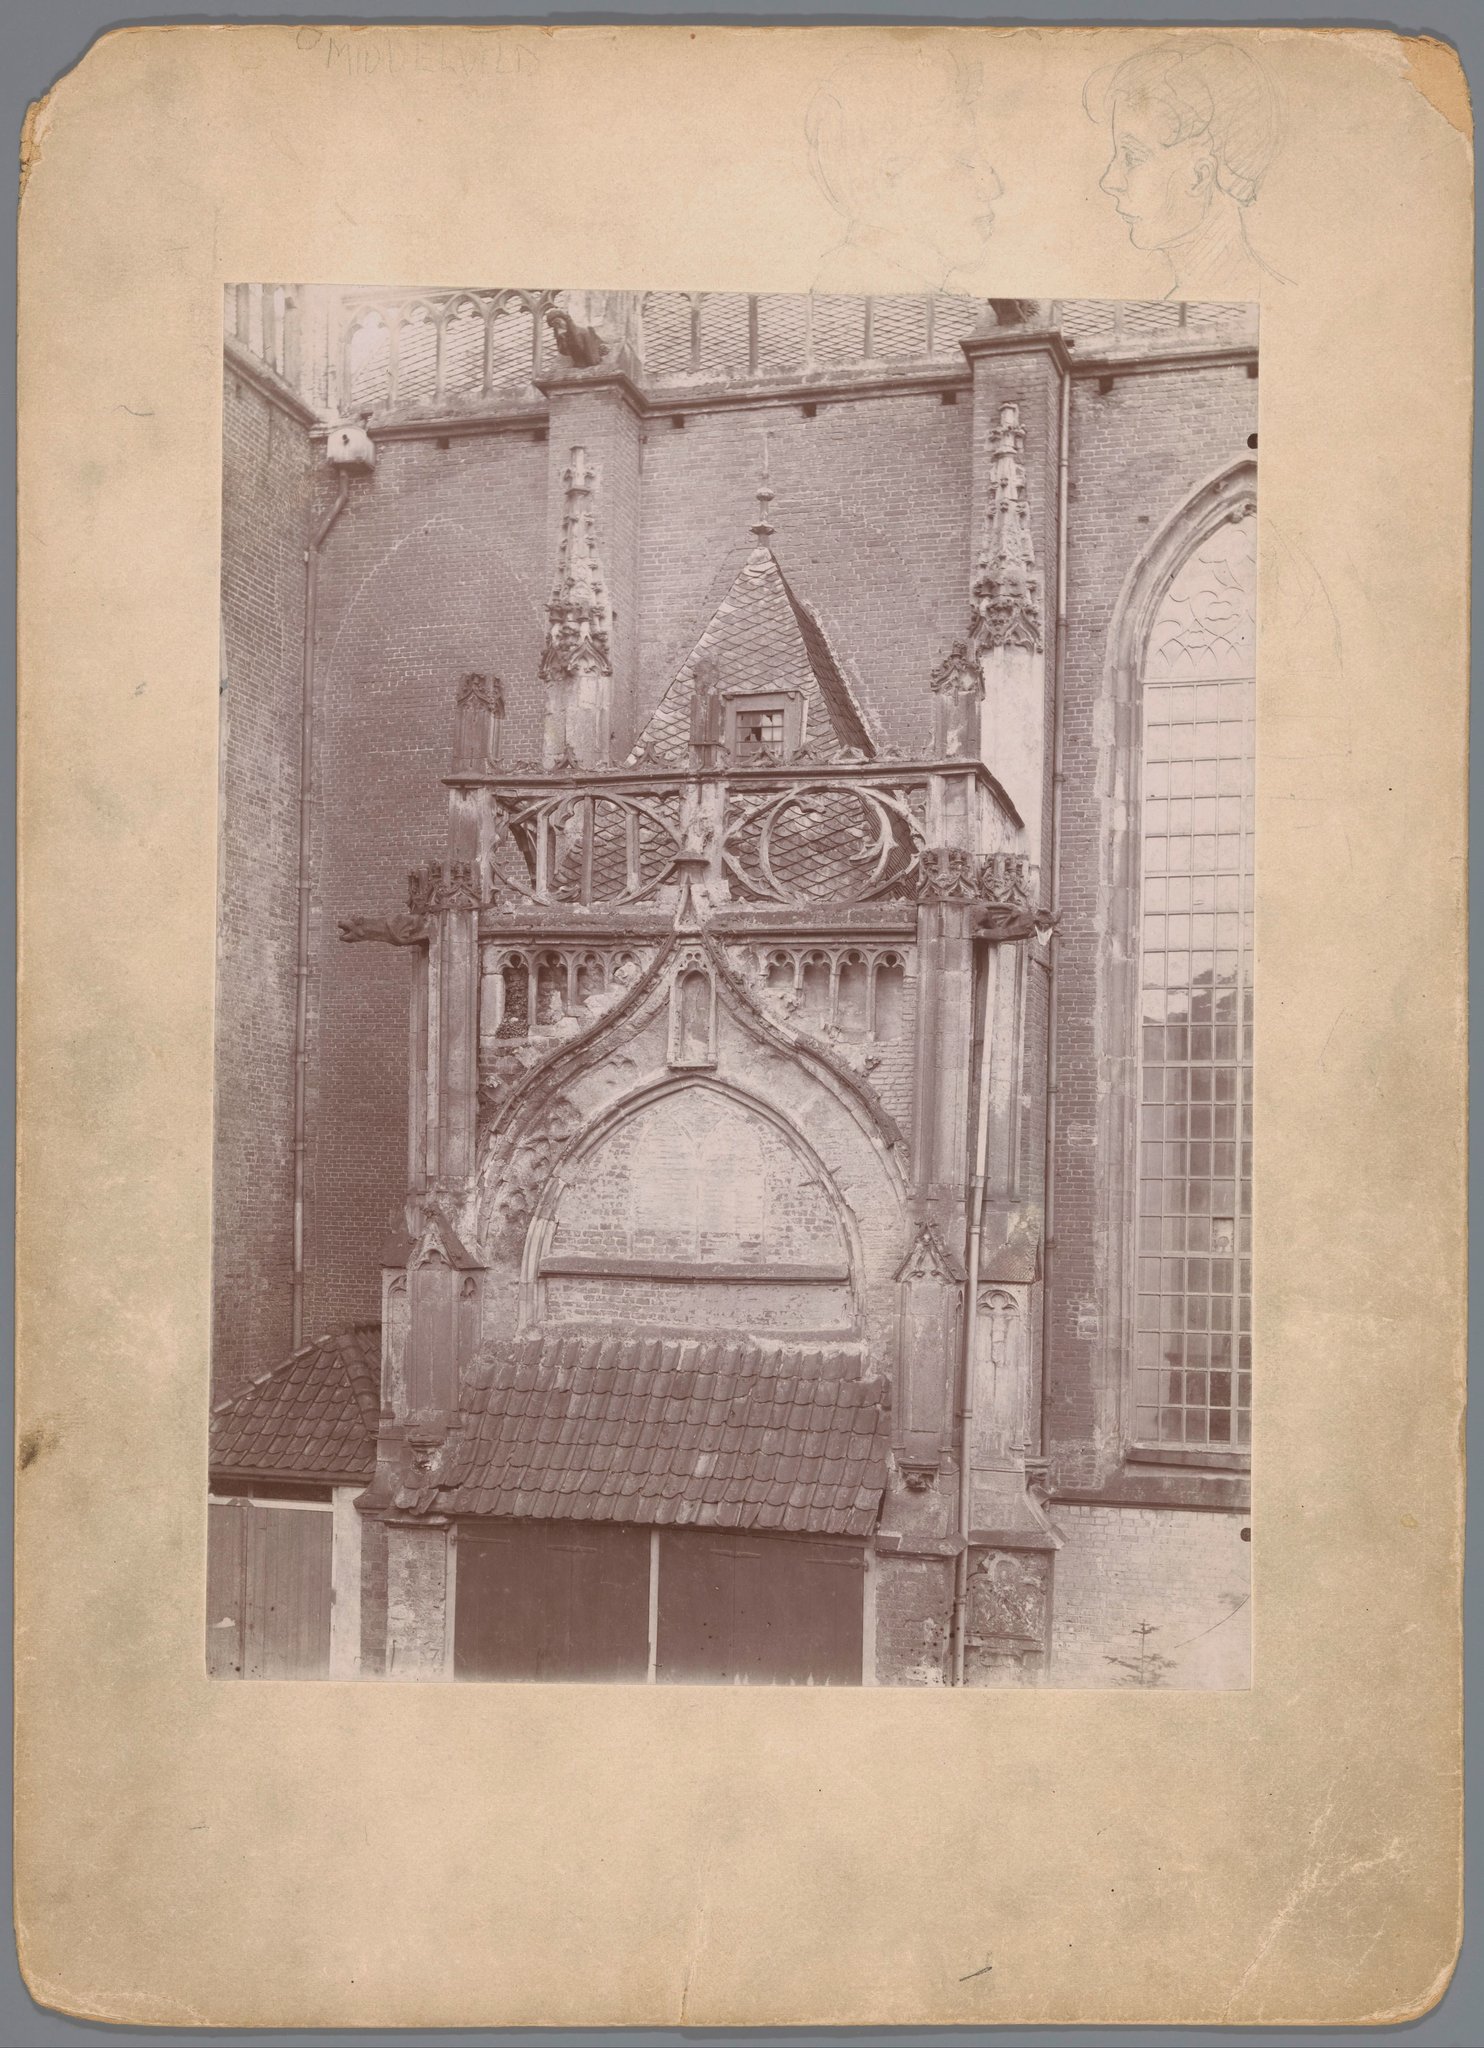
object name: photograph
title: Deel van het Mariaportaal van de Walburgiskerk te Zutphen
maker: Anonymous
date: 1875-1890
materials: cardboard, photographic support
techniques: daylight paper print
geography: zutphen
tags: parts of church exterior and annexes: portal, façade (of house or building)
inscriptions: collector's mark: Lugt 3937, annotation:, annotation:, inscription: ‘Zutphen Portaal aan de Noordzijde der N. H. kerk.’